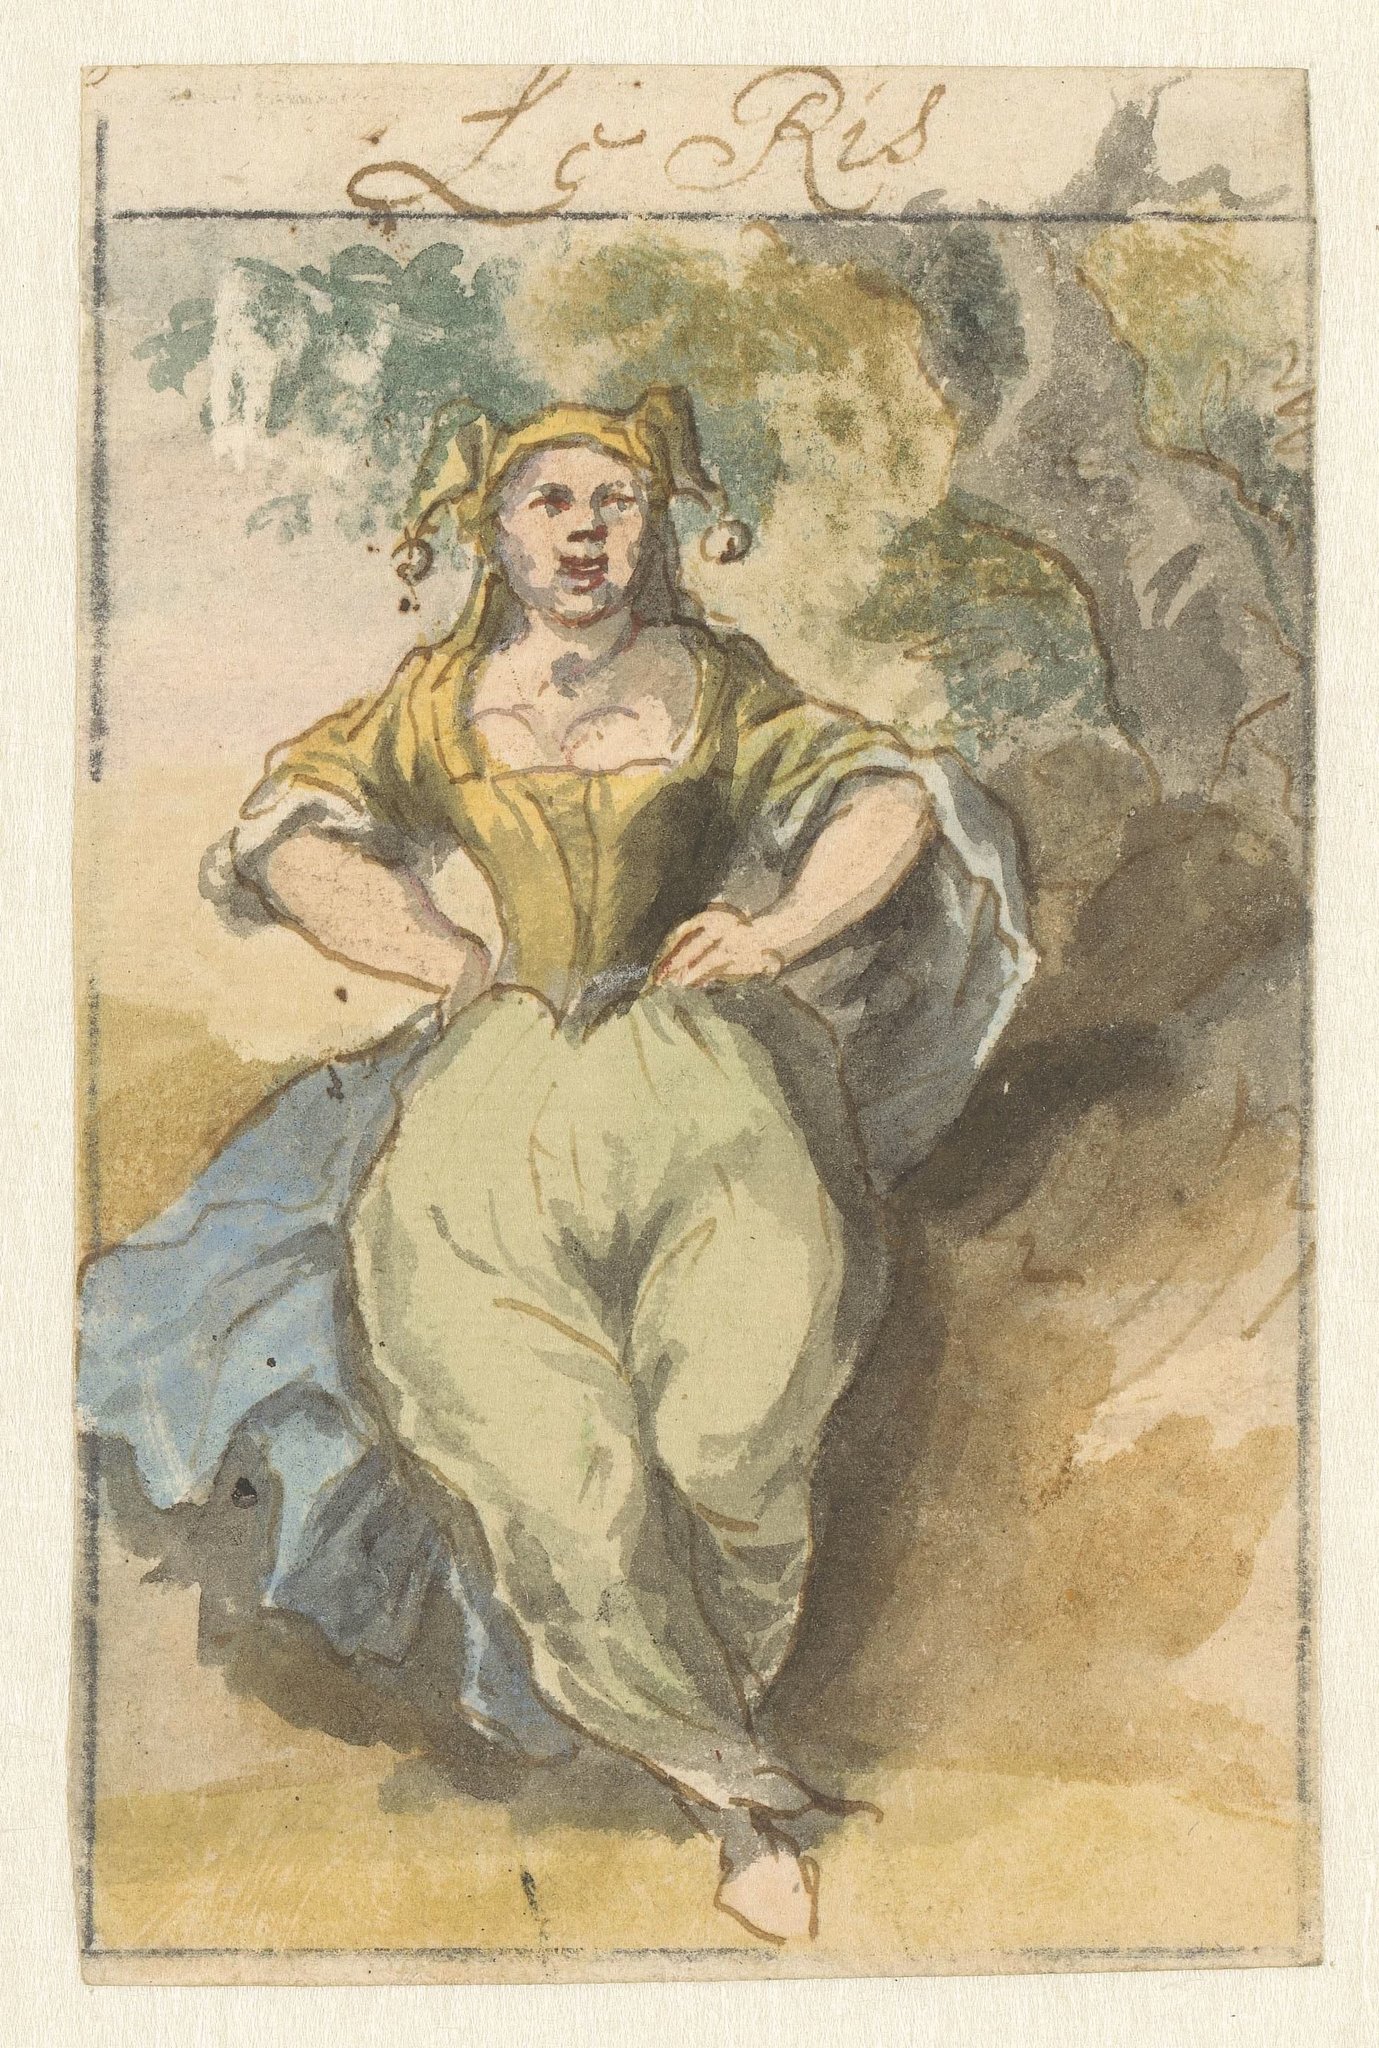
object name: drawing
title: Uitbeeldingen van karakters, eigenschappen, deugden en ondeugden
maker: pieter van den berge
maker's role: draughtsman, print maker, printer, publisher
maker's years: 1659-1737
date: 1675-1737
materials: chalk, ink, paper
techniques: brush, pen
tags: folly, foolishness; 'pazzia', 'sciocchezza', 'stoltitia' (ripa) (+ personification)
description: Een vrouw, en face, onder een boom gezeten, met een zotskap op en de handen in de zij.